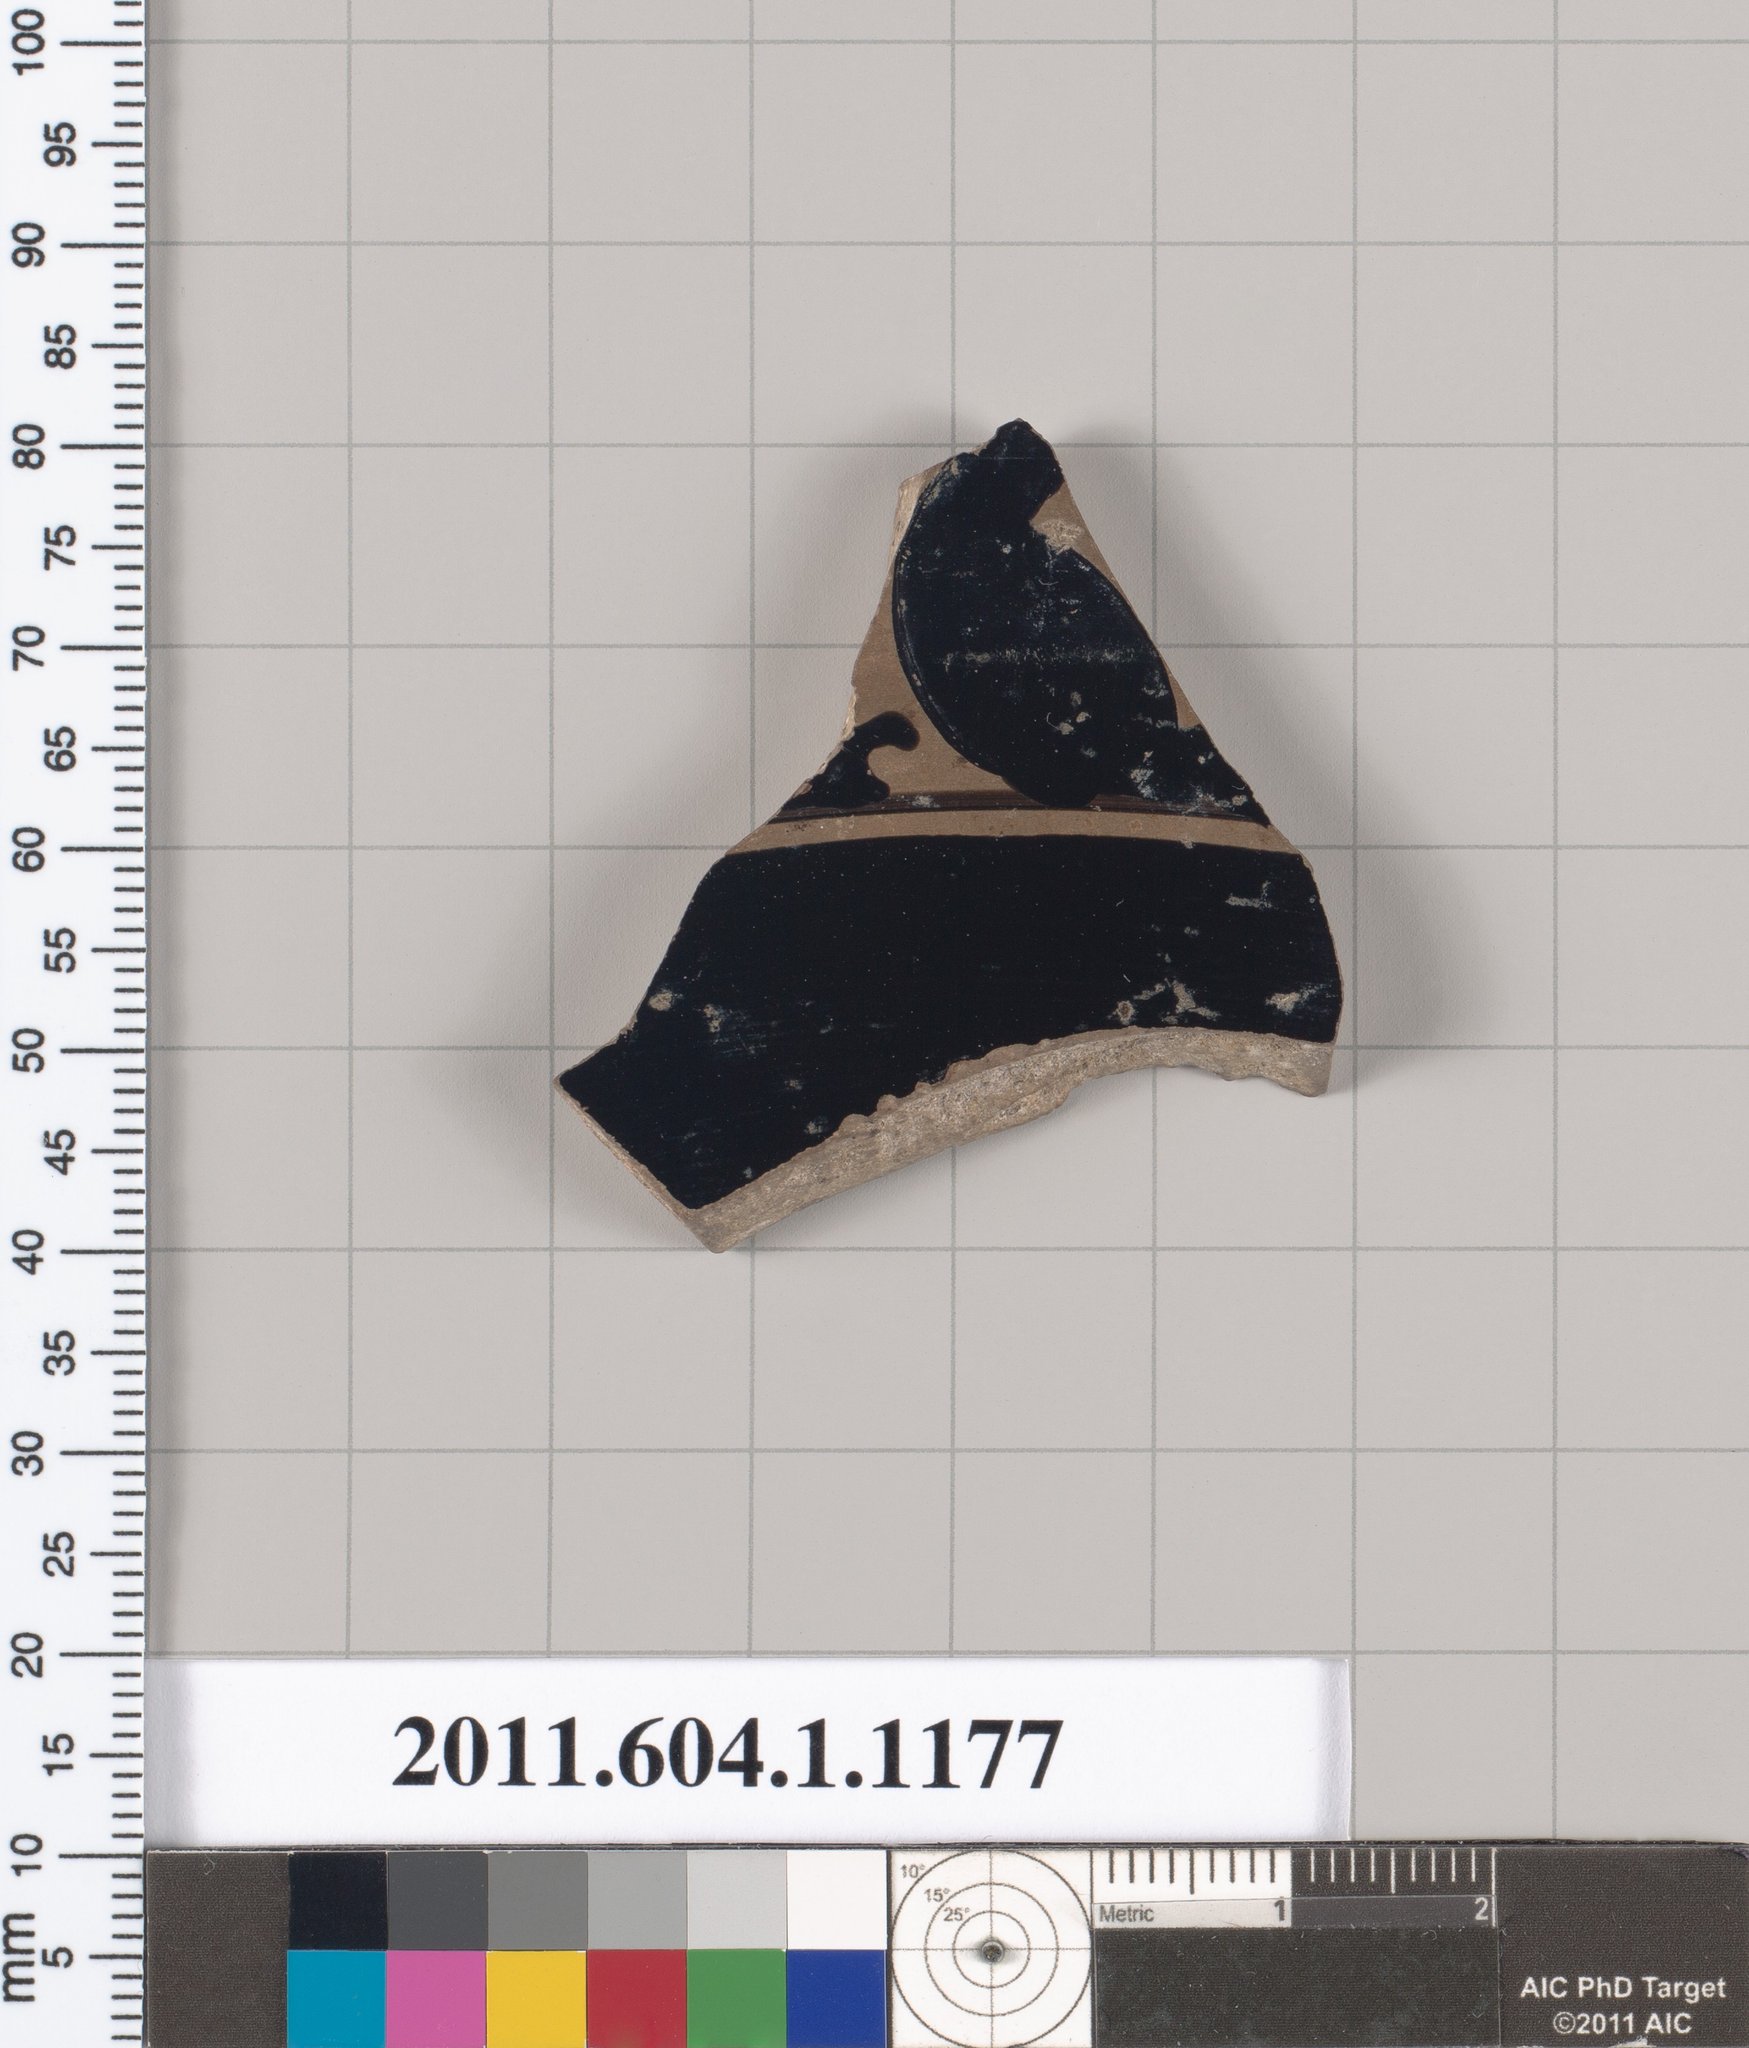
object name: kylix fragment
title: Terracotta fragment of a kylix (drinking cup)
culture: greek, attic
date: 490-480 BCE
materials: terracotta